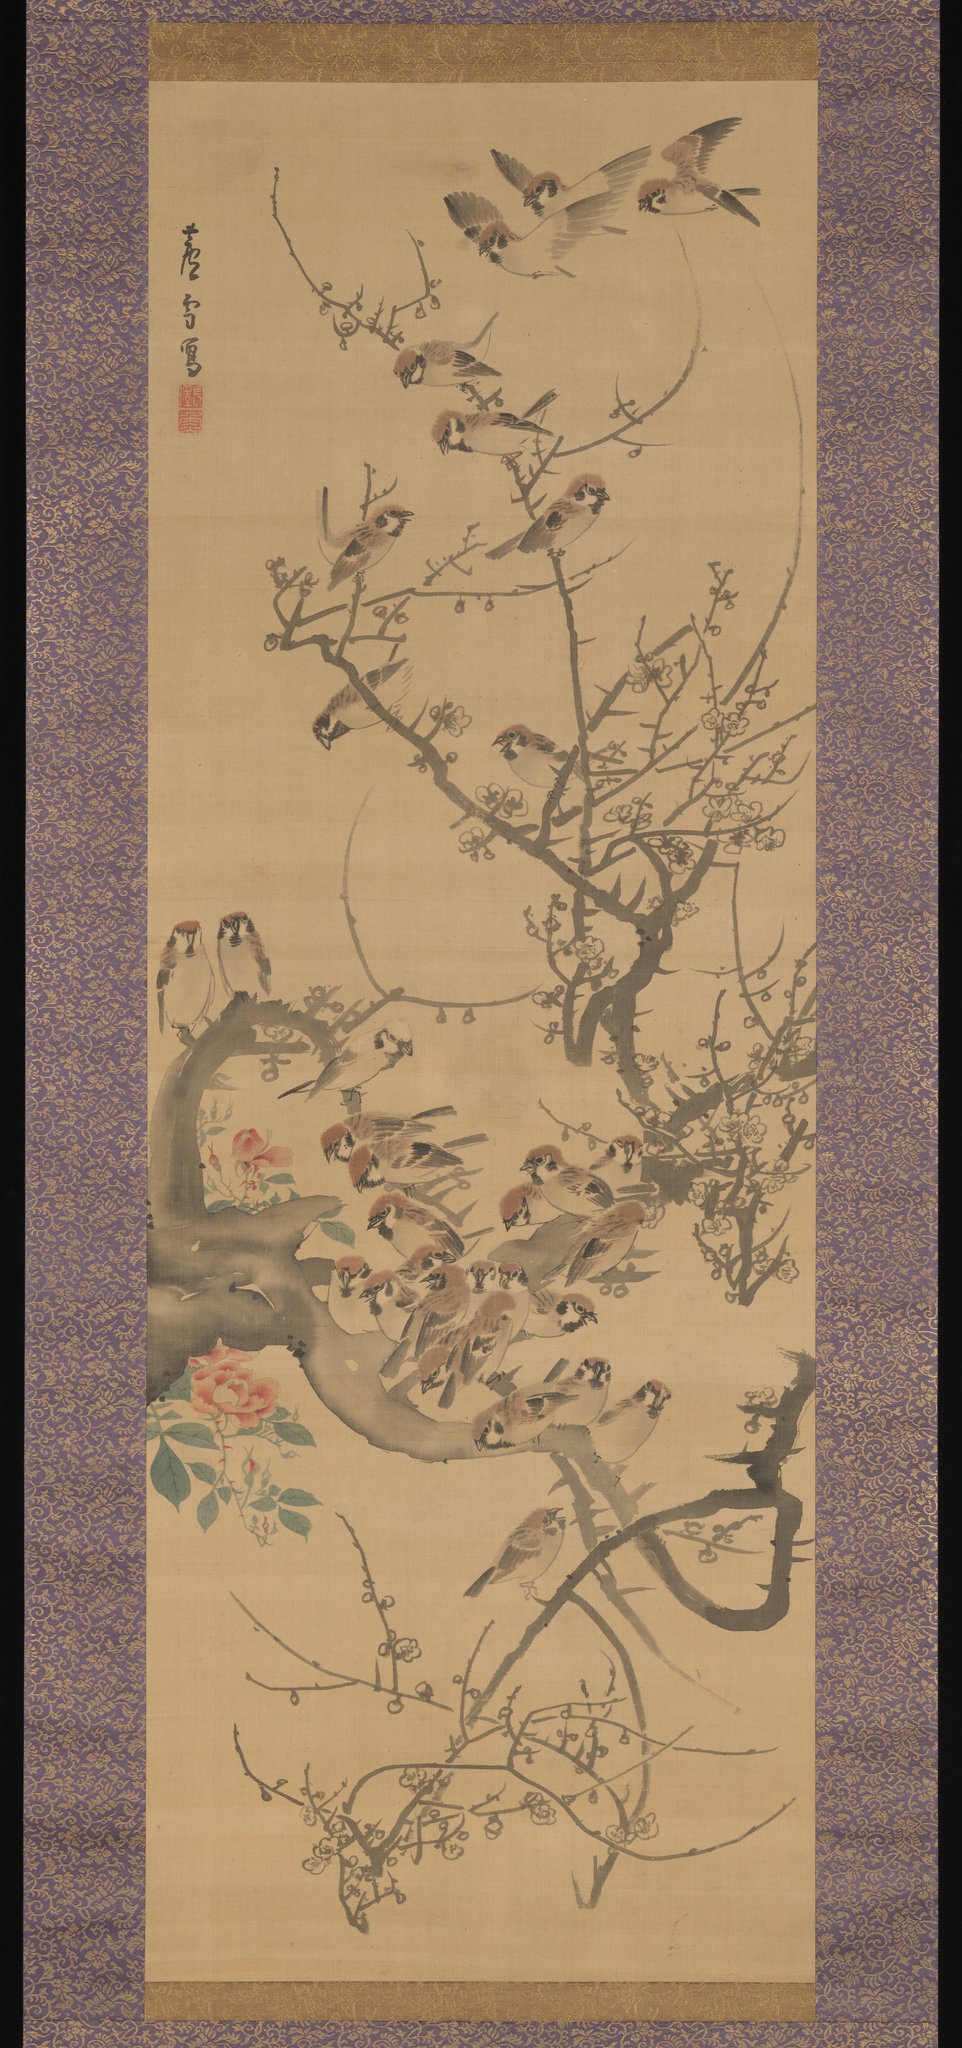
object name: hanging scroll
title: Sparrows in a Plum Tree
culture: japanese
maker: nagasawa rosetsu 長澤蘆雪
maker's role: artist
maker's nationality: japanese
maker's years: 1754-1799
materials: ink, silk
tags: birds,trees